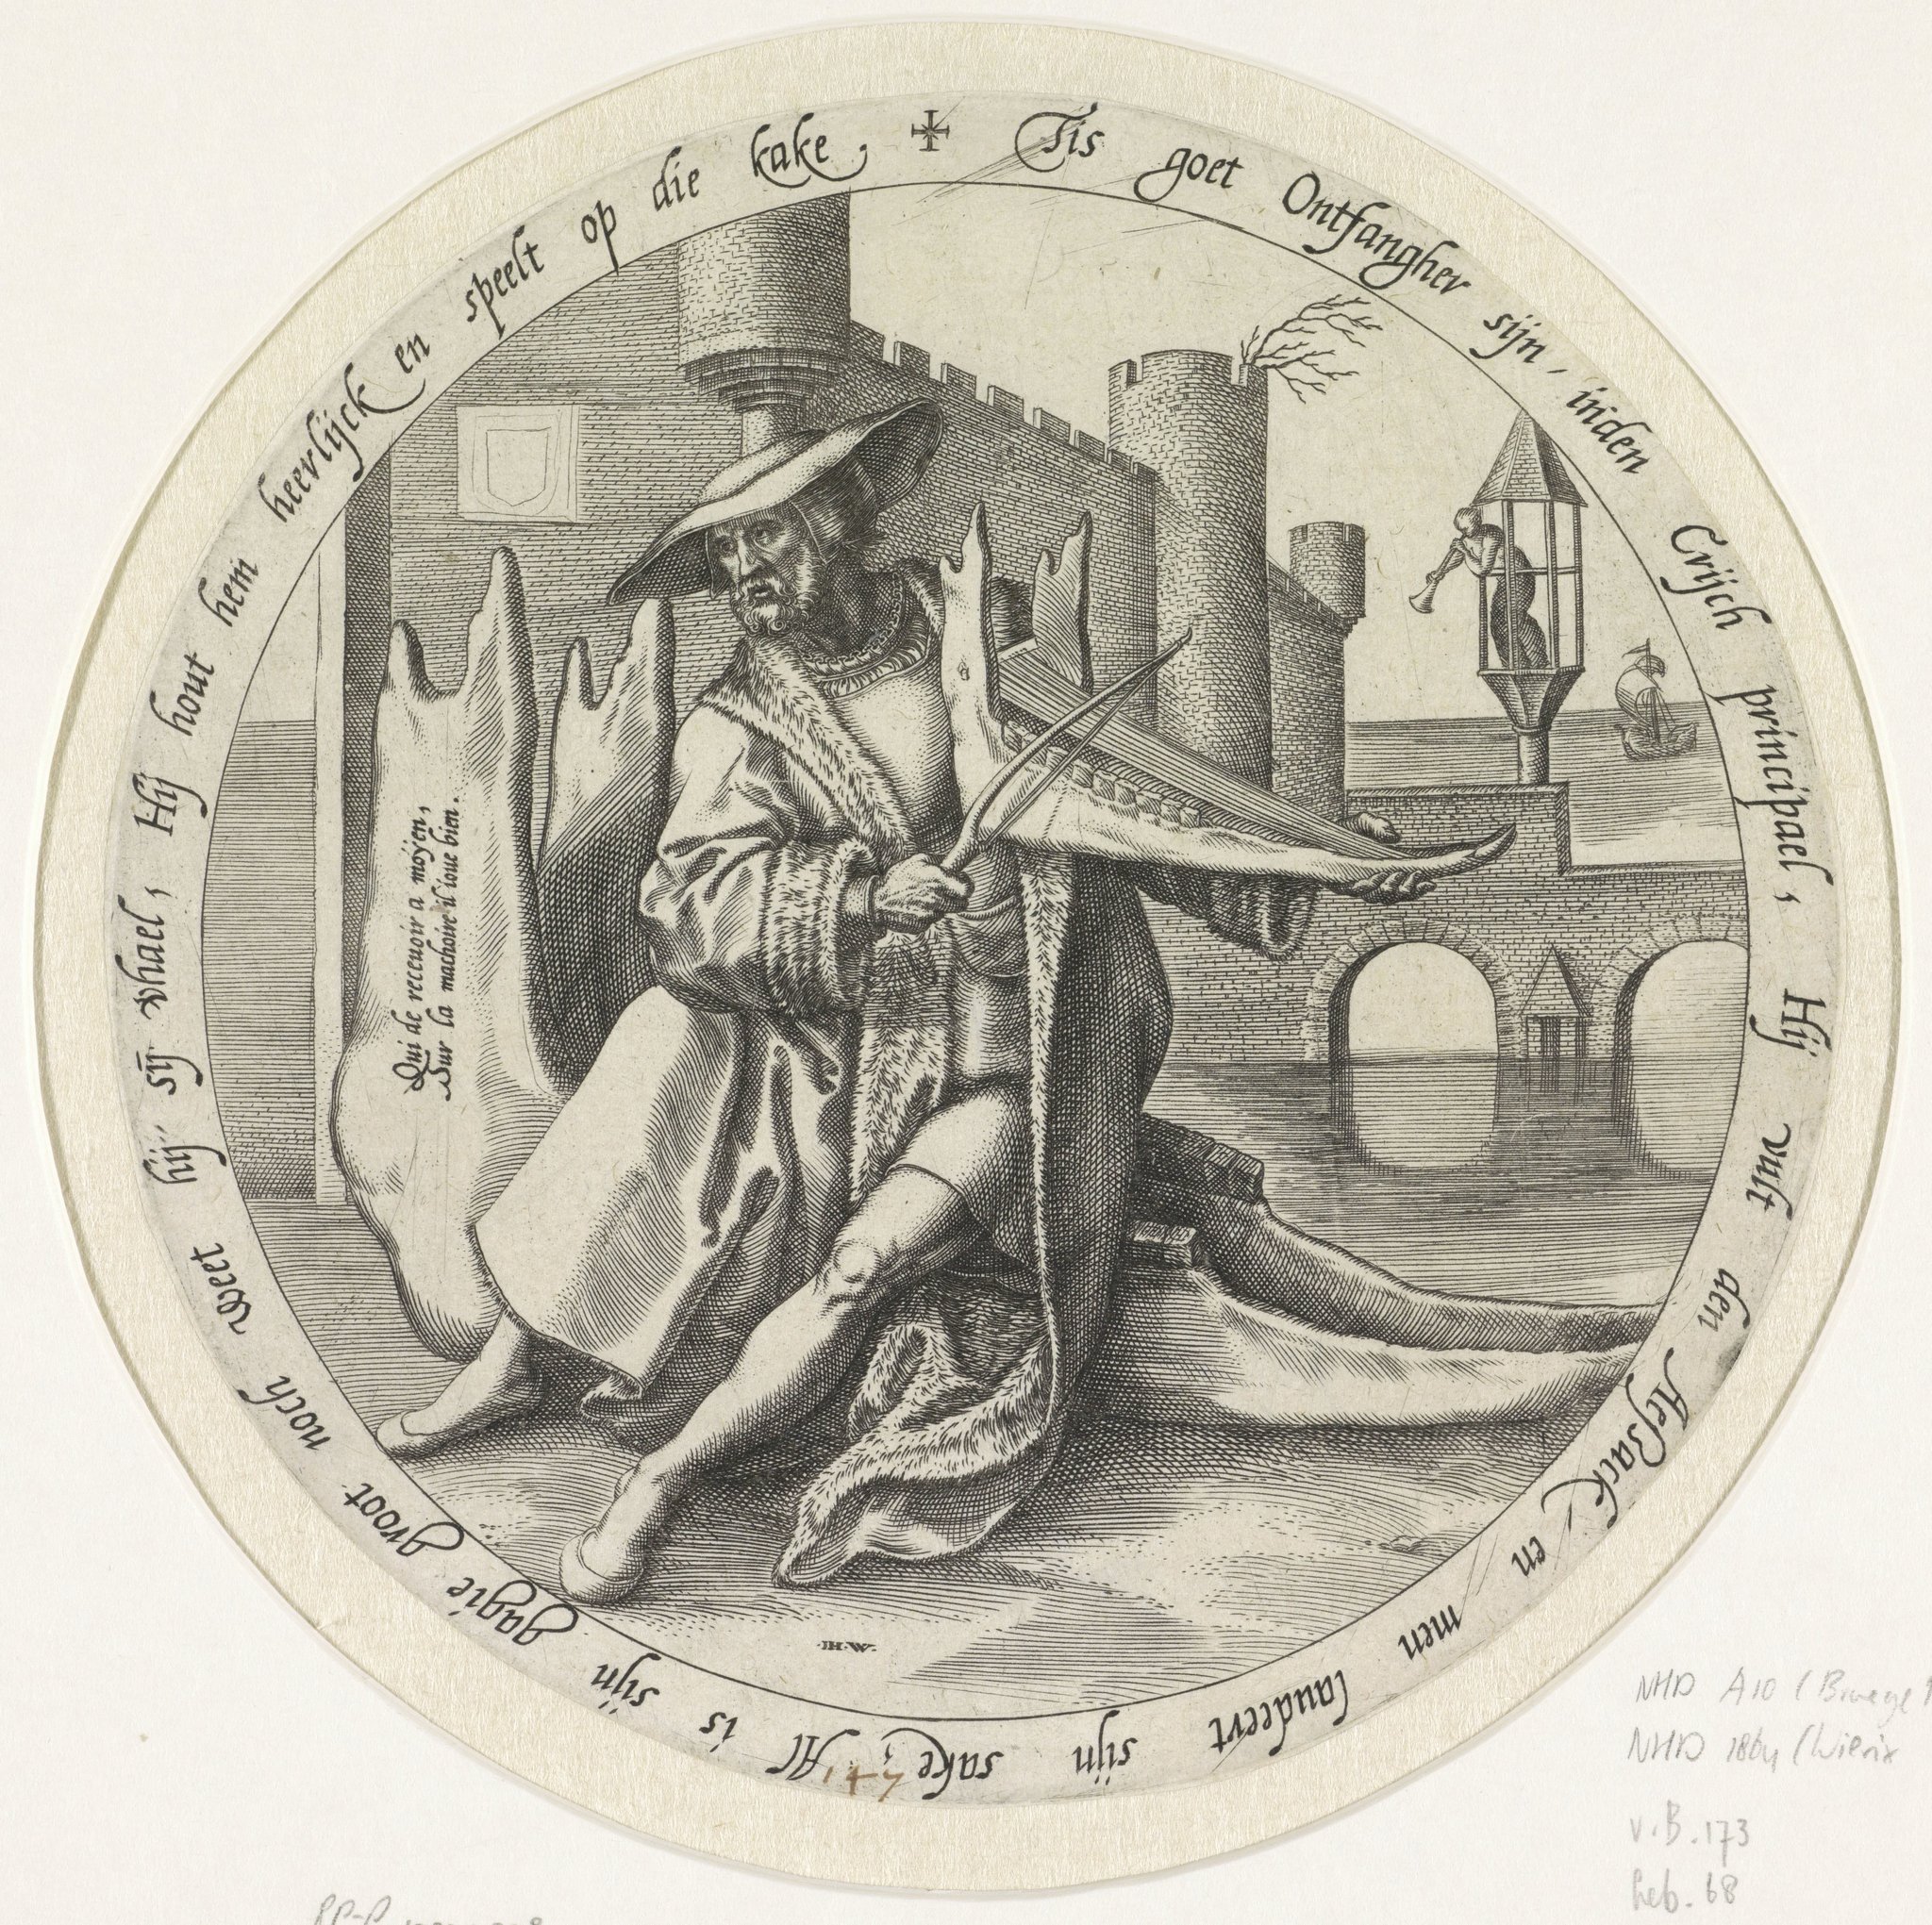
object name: print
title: Vlaamse spreekwoorden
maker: johannes wierix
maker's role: draughtsman, print maker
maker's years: 1549-1618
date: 1566-1570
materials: paper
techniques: engraving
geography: antwerp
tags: violin, fiddle (+ variant), proverbs, sayings, etc.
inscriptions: collector's mark: Lugt 2228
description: Een rijke man gekleed in bontmantel speelt zittend op een kaakbeen, viool op een kaakbeen. In het randschrift een toelichting op de voorstelling en op het spreekwoord in het Nederlands.